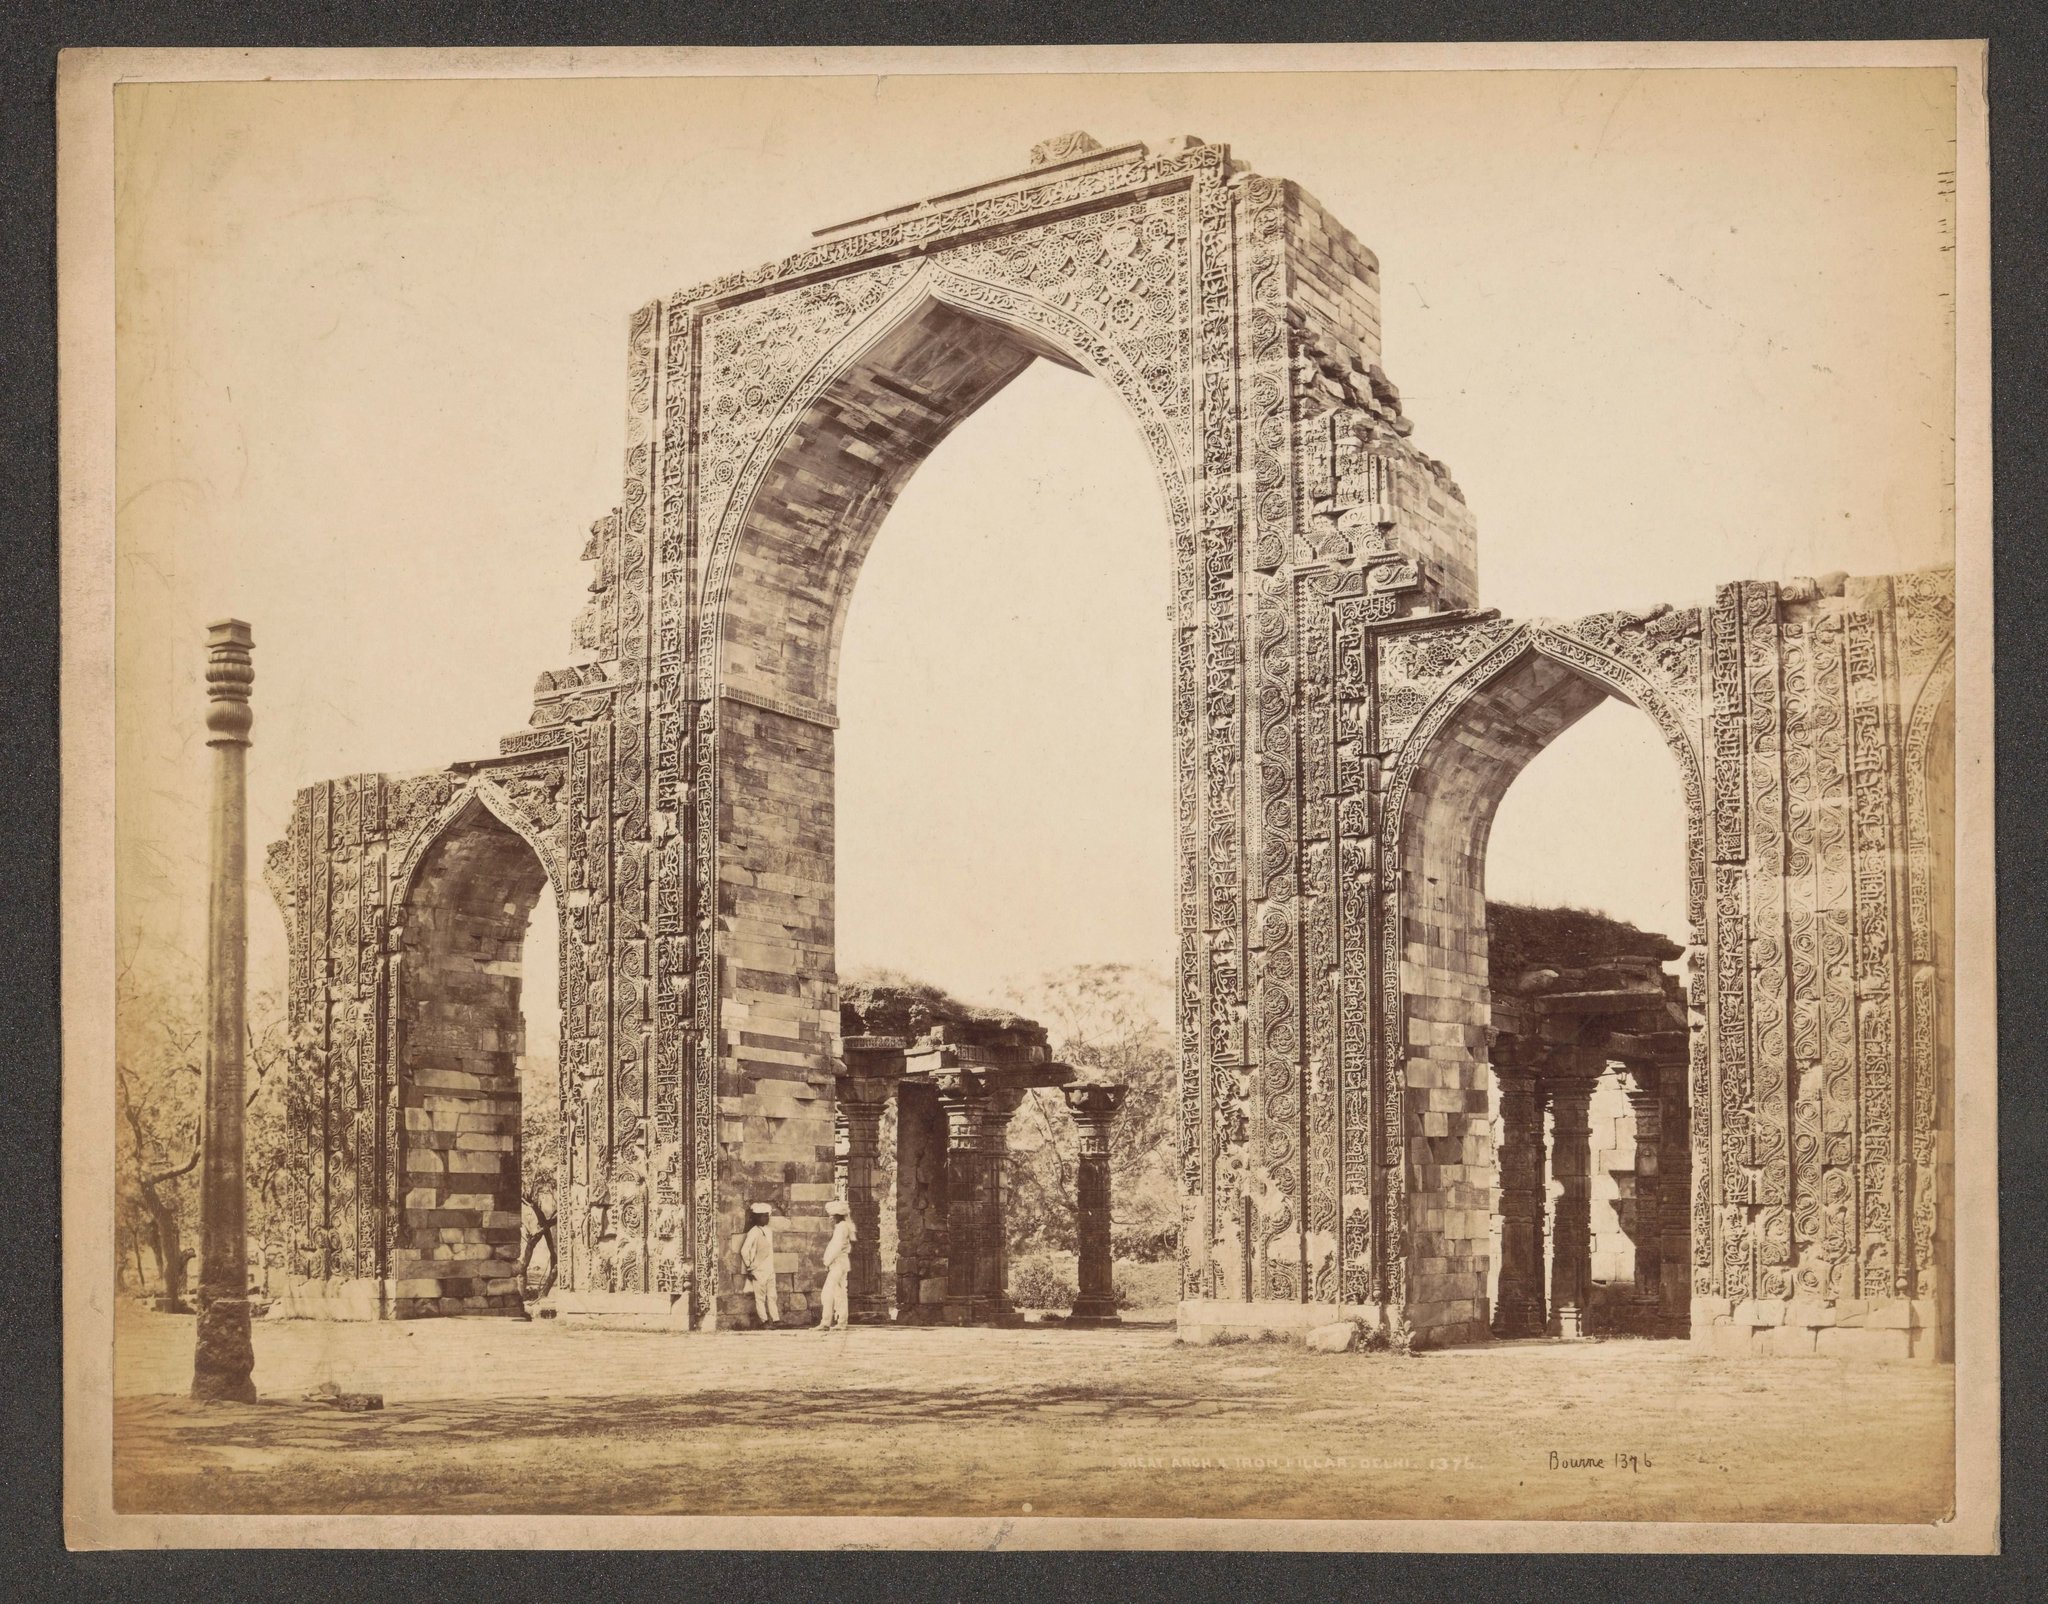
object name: photograph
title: Iron Pillar and ruins of the Quwwat-ul-Islam mosque, Delhi, India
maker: samuel bourne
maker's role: fotograaf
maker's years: 1834-1912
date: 1862-1864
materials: cardboard, paper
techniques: albumen print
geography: delhi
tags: ruin of a building ~ architecture, gate, entrance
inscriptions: name: ‘Bourne’, number: ‘1376/ 1376’, title: ‘Great Arch & Iron Pillar. Delhi.’, number: ‘40’